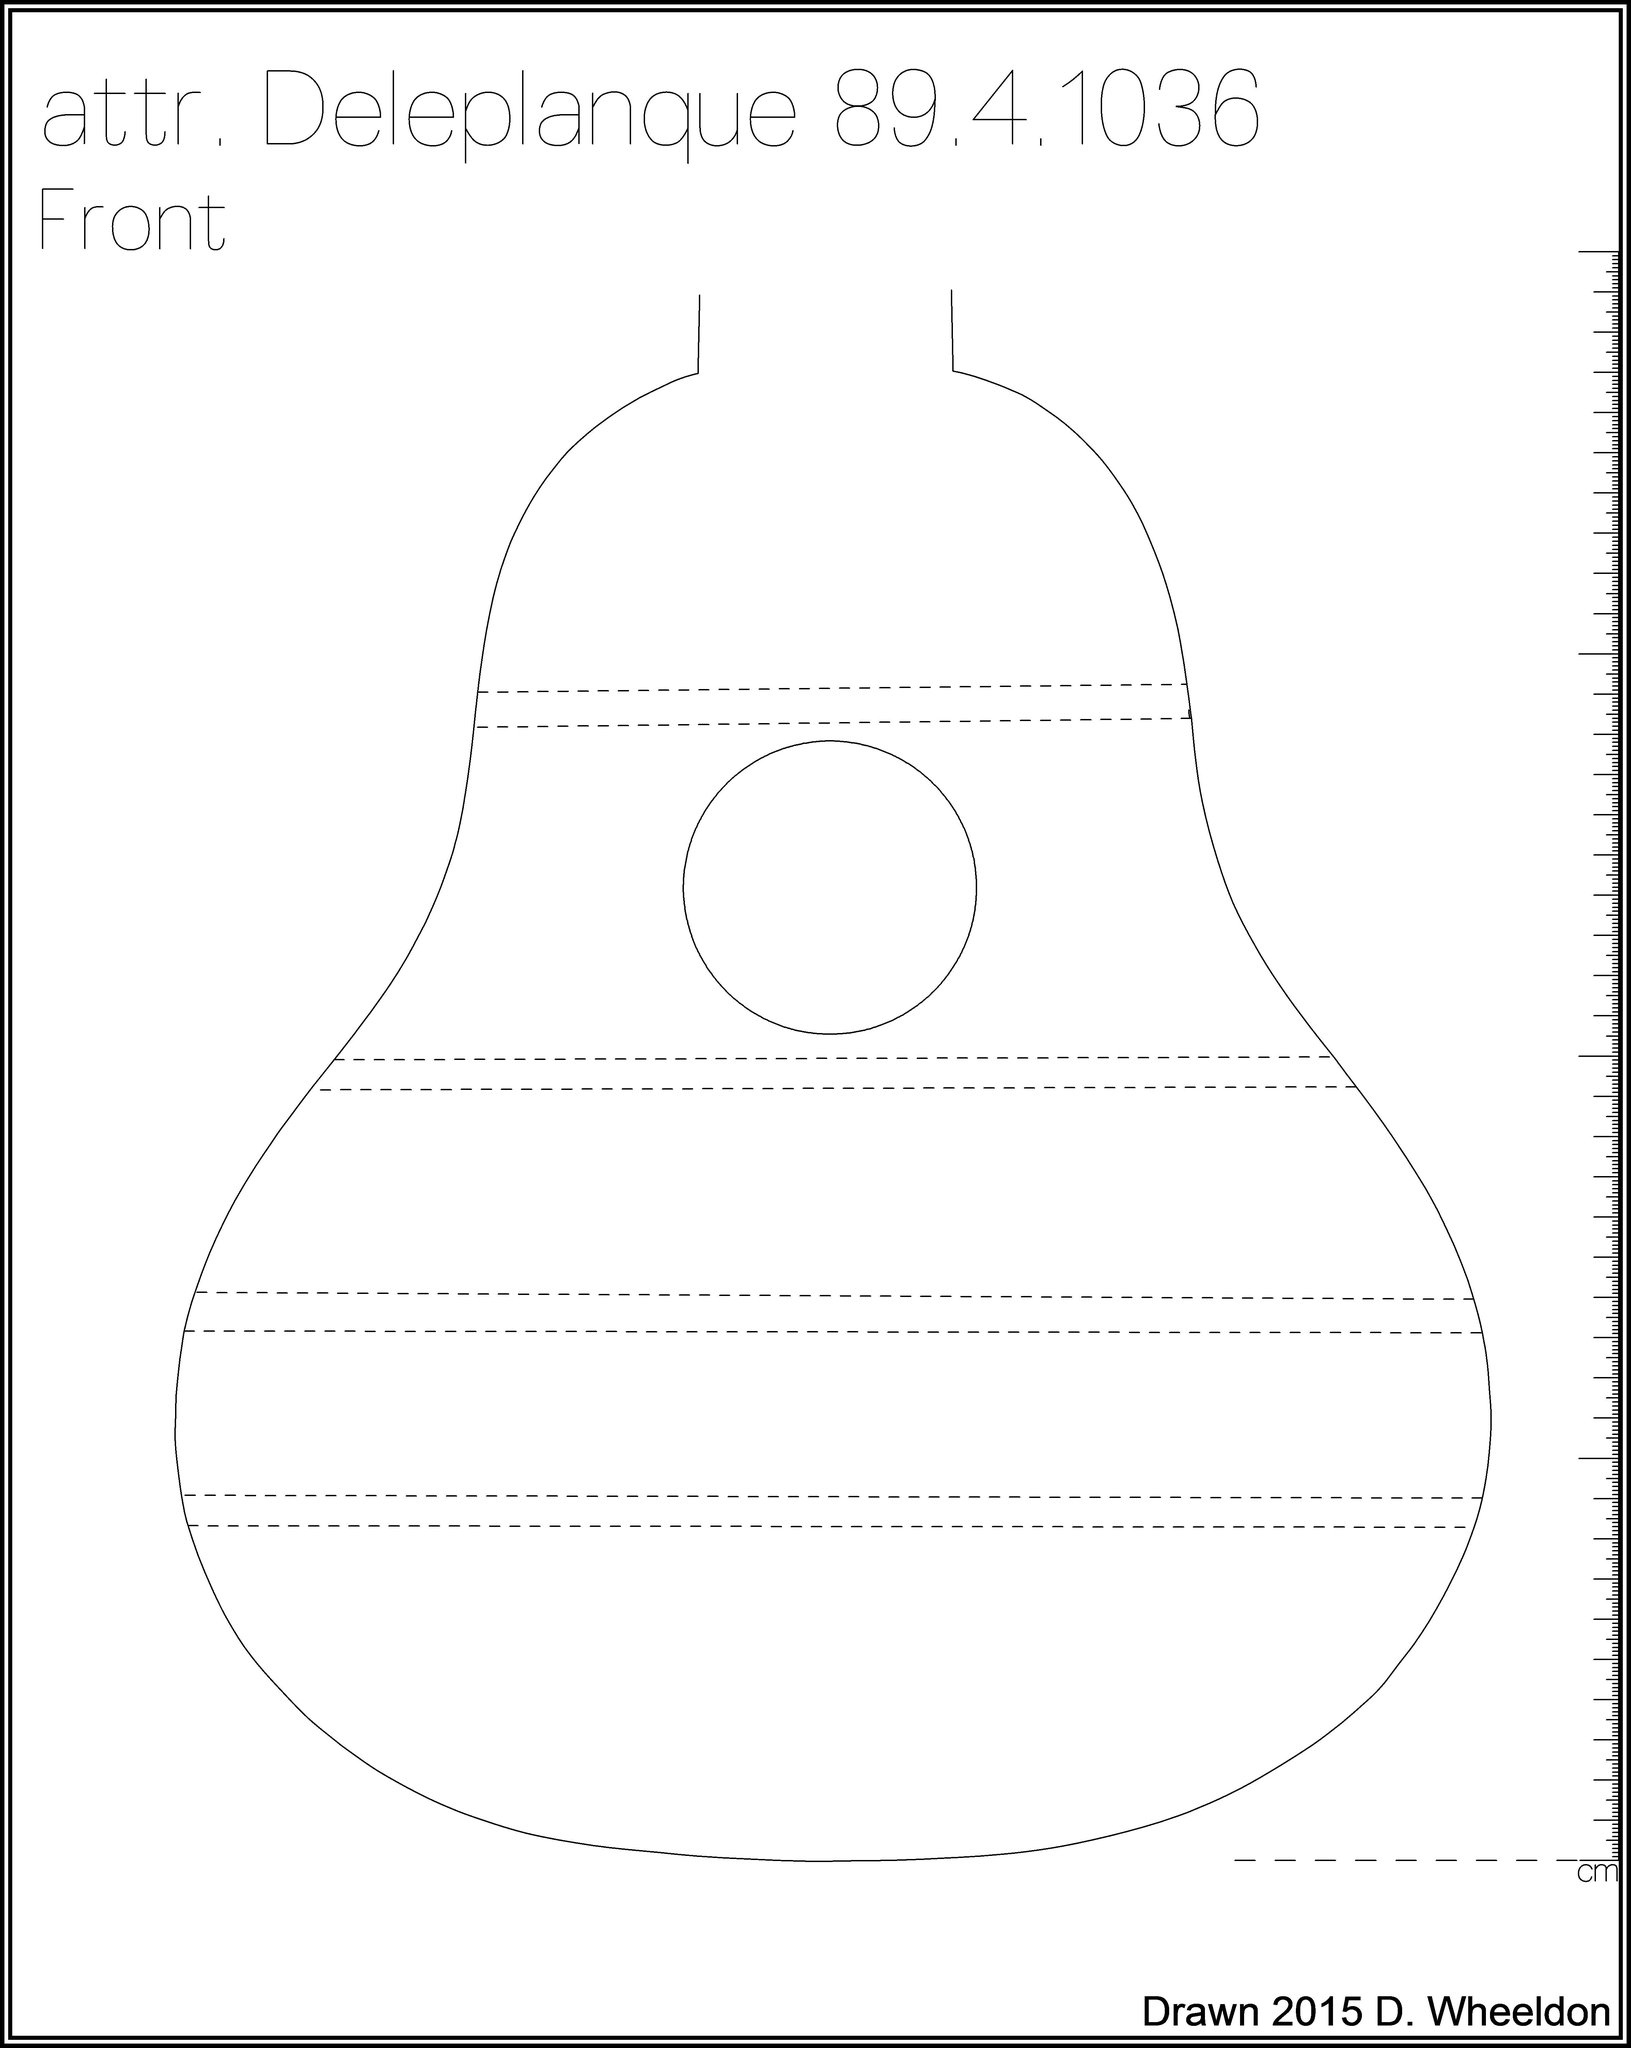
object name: cittern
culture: french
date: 1701-1800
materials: brass, ivory, steel, wood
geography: france